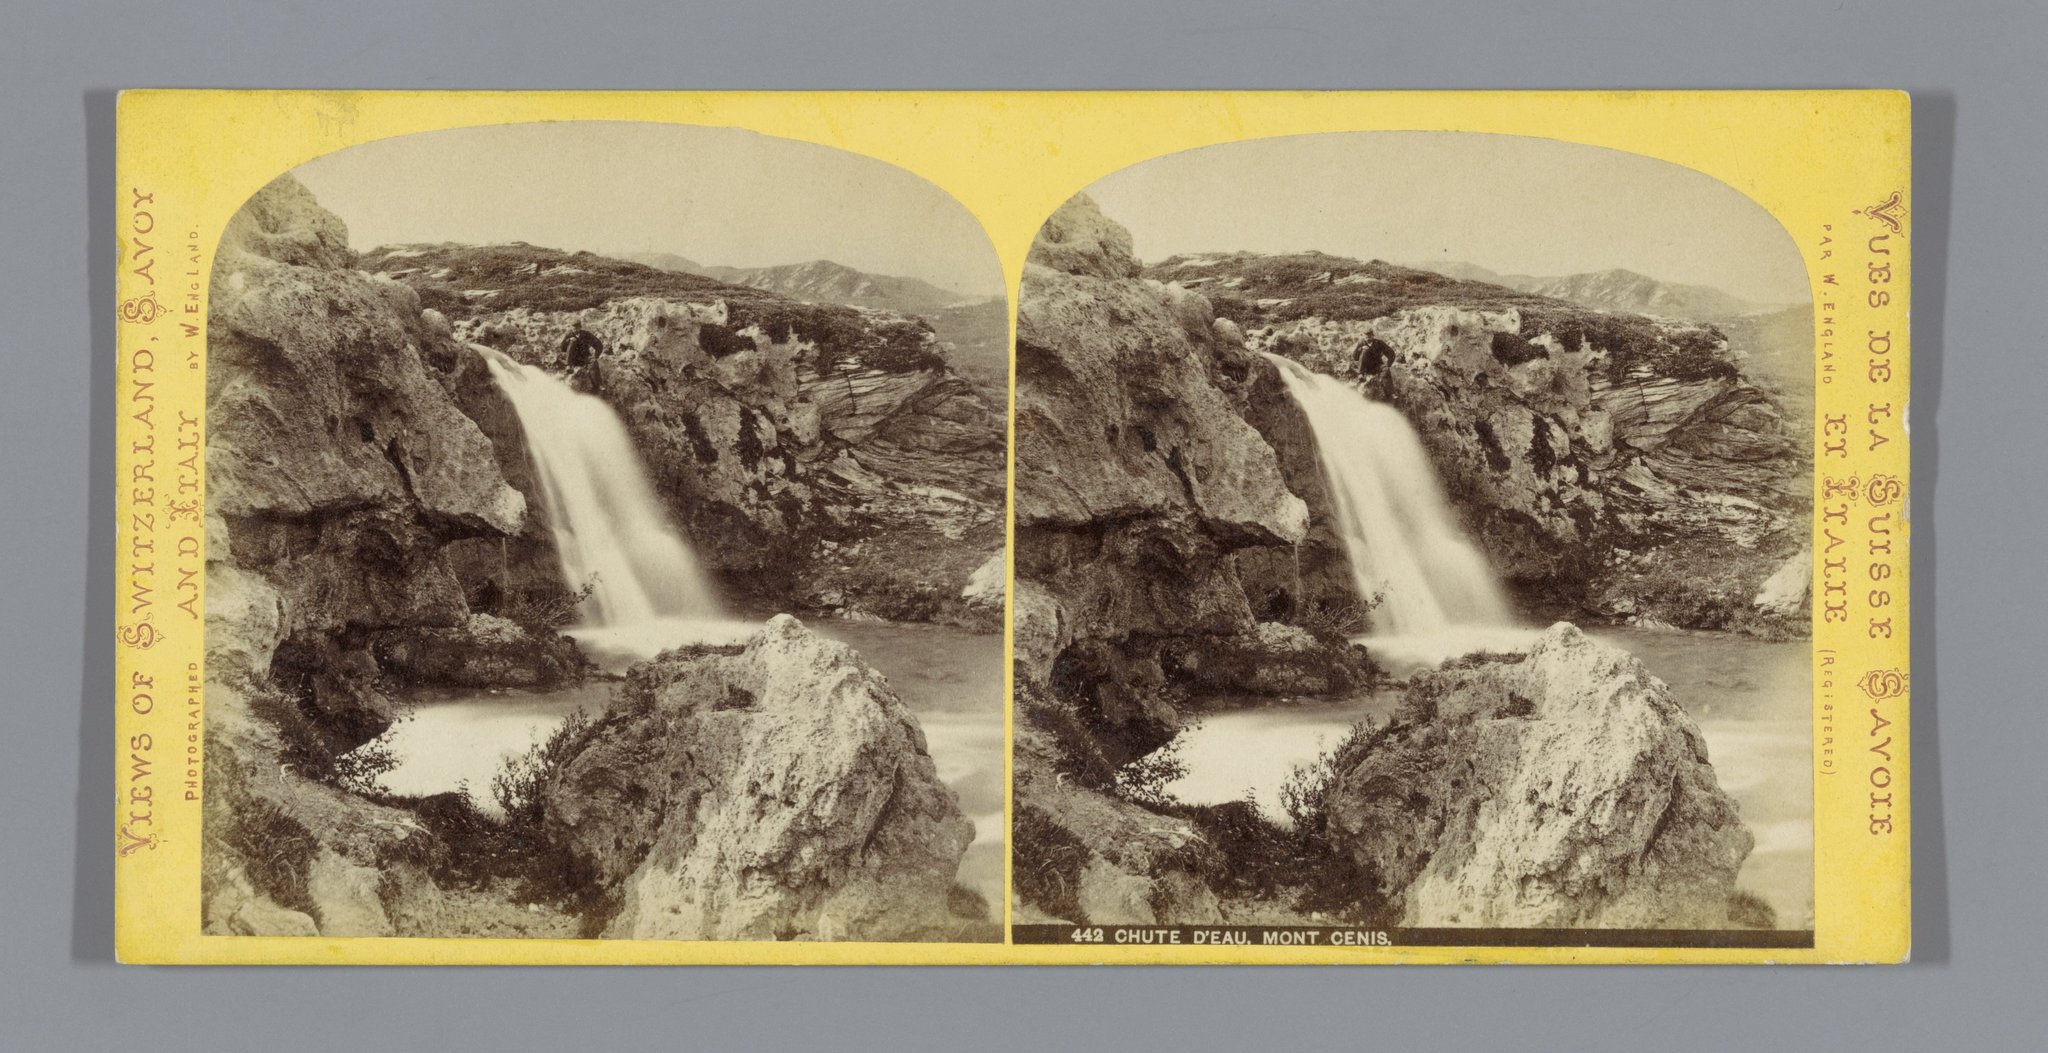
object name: stereograph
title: Chute d'eau, Mont Cenis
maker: william england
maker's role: fotograaf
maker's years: 1816-1896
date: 1850-1880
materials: cardboard, photographic support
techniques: albumen print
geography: col du mont cenis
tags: waterfall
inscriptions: inscription: ‘Vues de la Suisse Savoie et Italie’, number: ‘442’